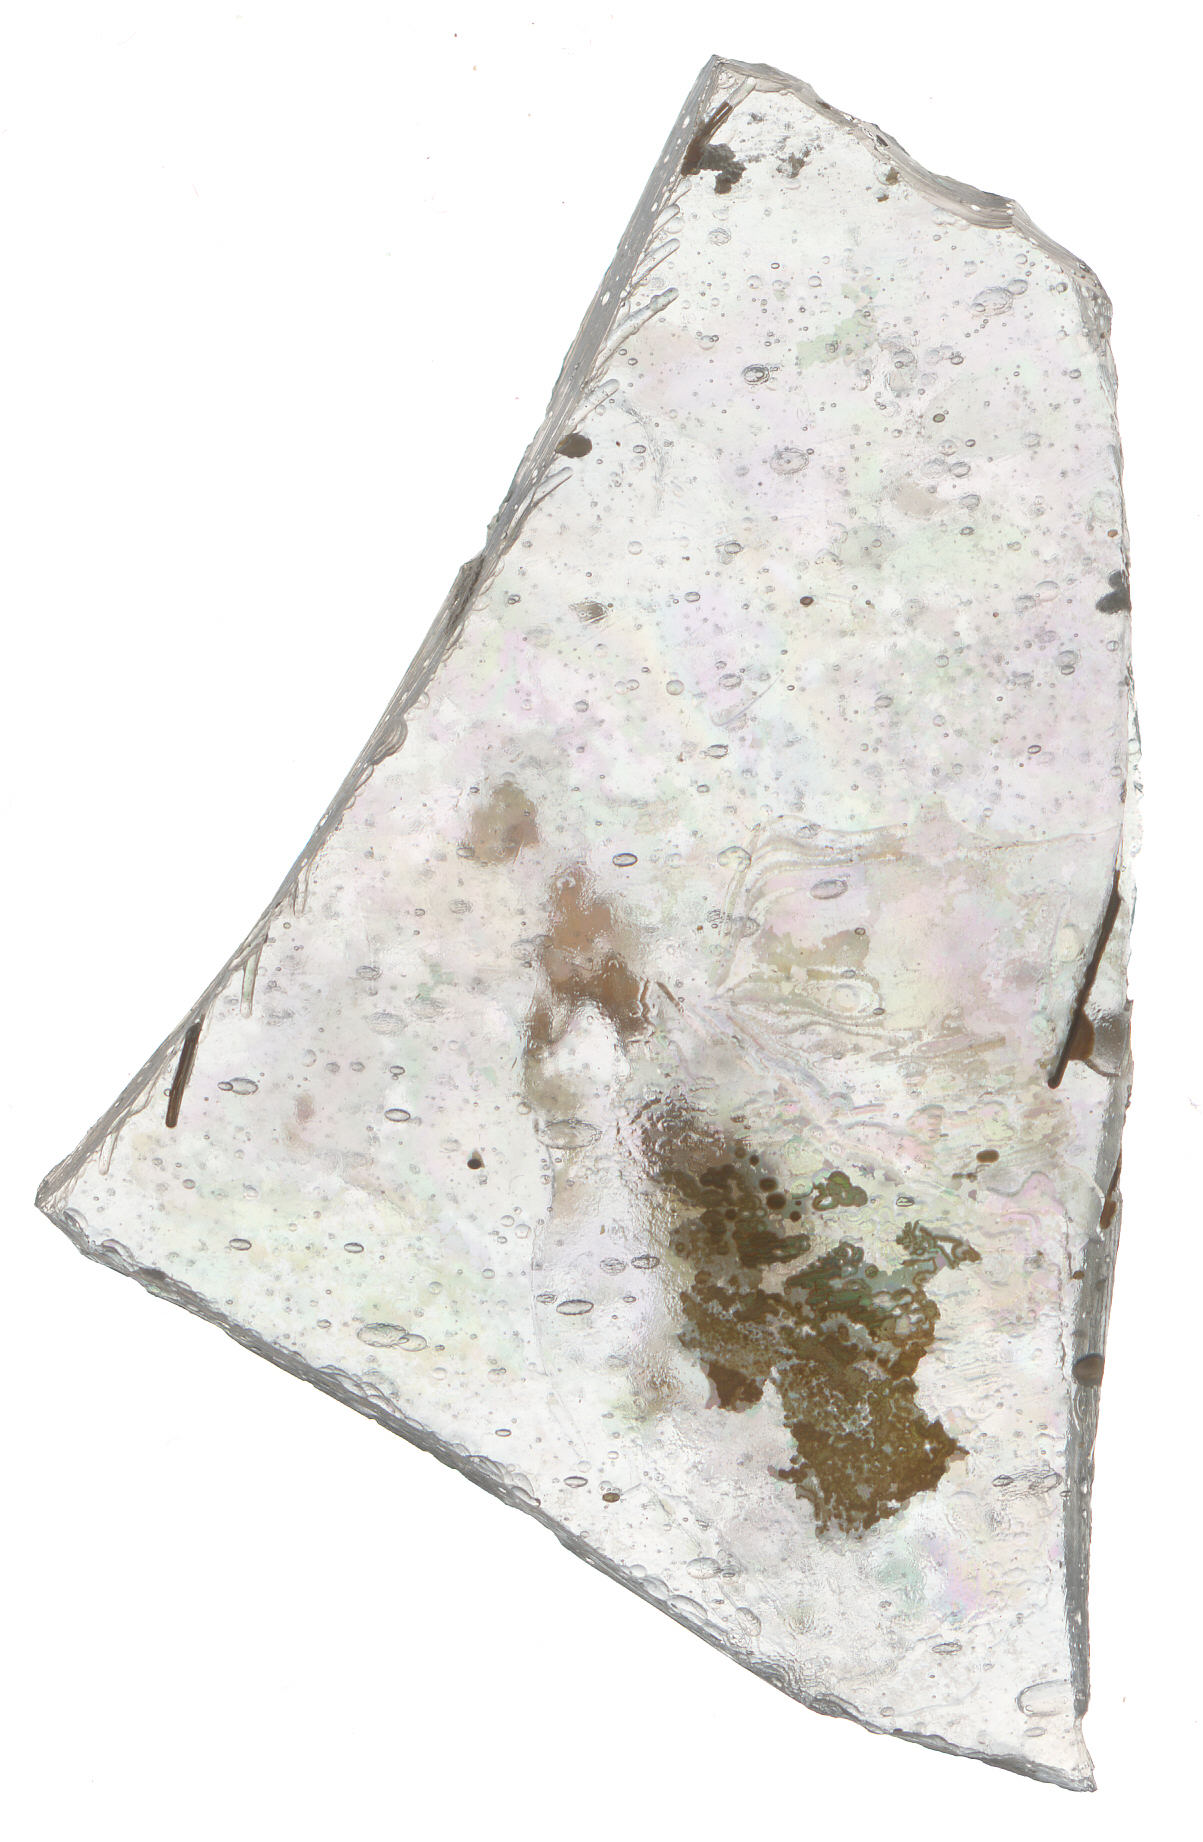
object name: fragment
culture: crusader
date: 1201-1300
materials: glass